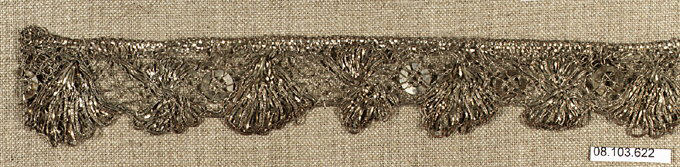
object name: piece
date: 1701-1800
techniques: lace